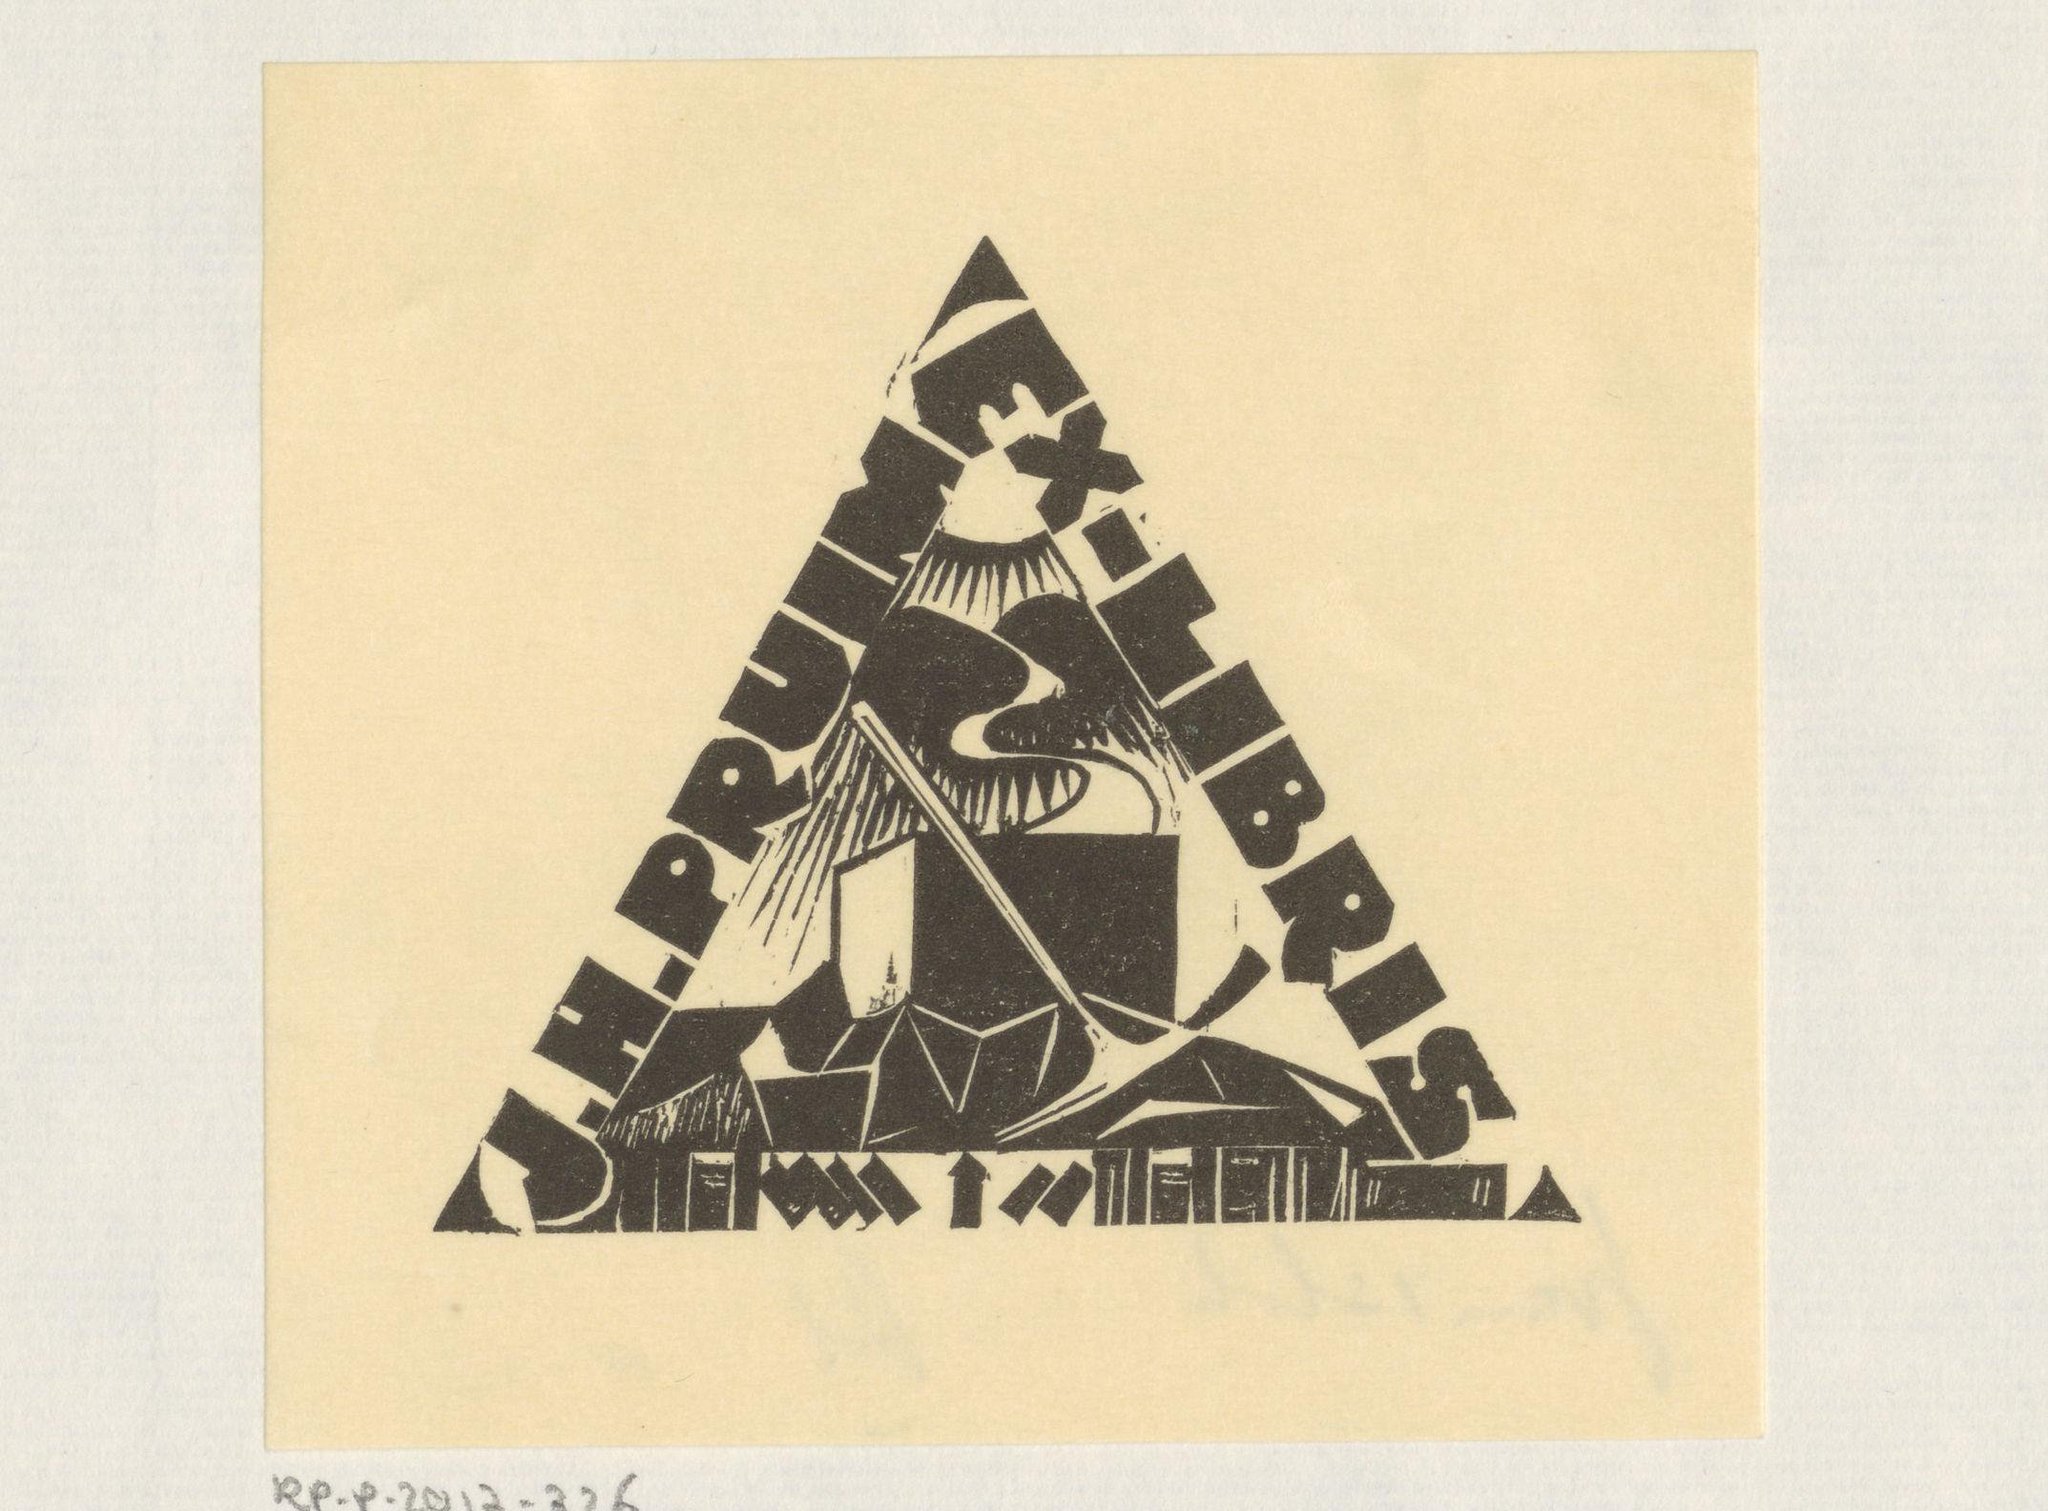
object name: bookplate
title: Ex libris van J.H. Pruim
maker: jan van t slot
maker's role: painter, print maker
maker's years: 1904-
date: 1940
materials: paper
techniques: woodcut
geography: netherlands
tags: quarry, tools, aids, implements ~ crafts and industries: pickaxe, mountains